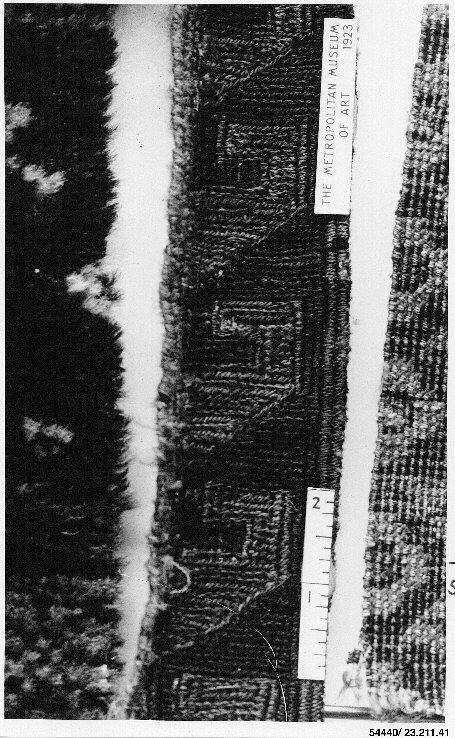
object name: carpet fragment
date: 1701-1800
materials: wool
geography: caucasus